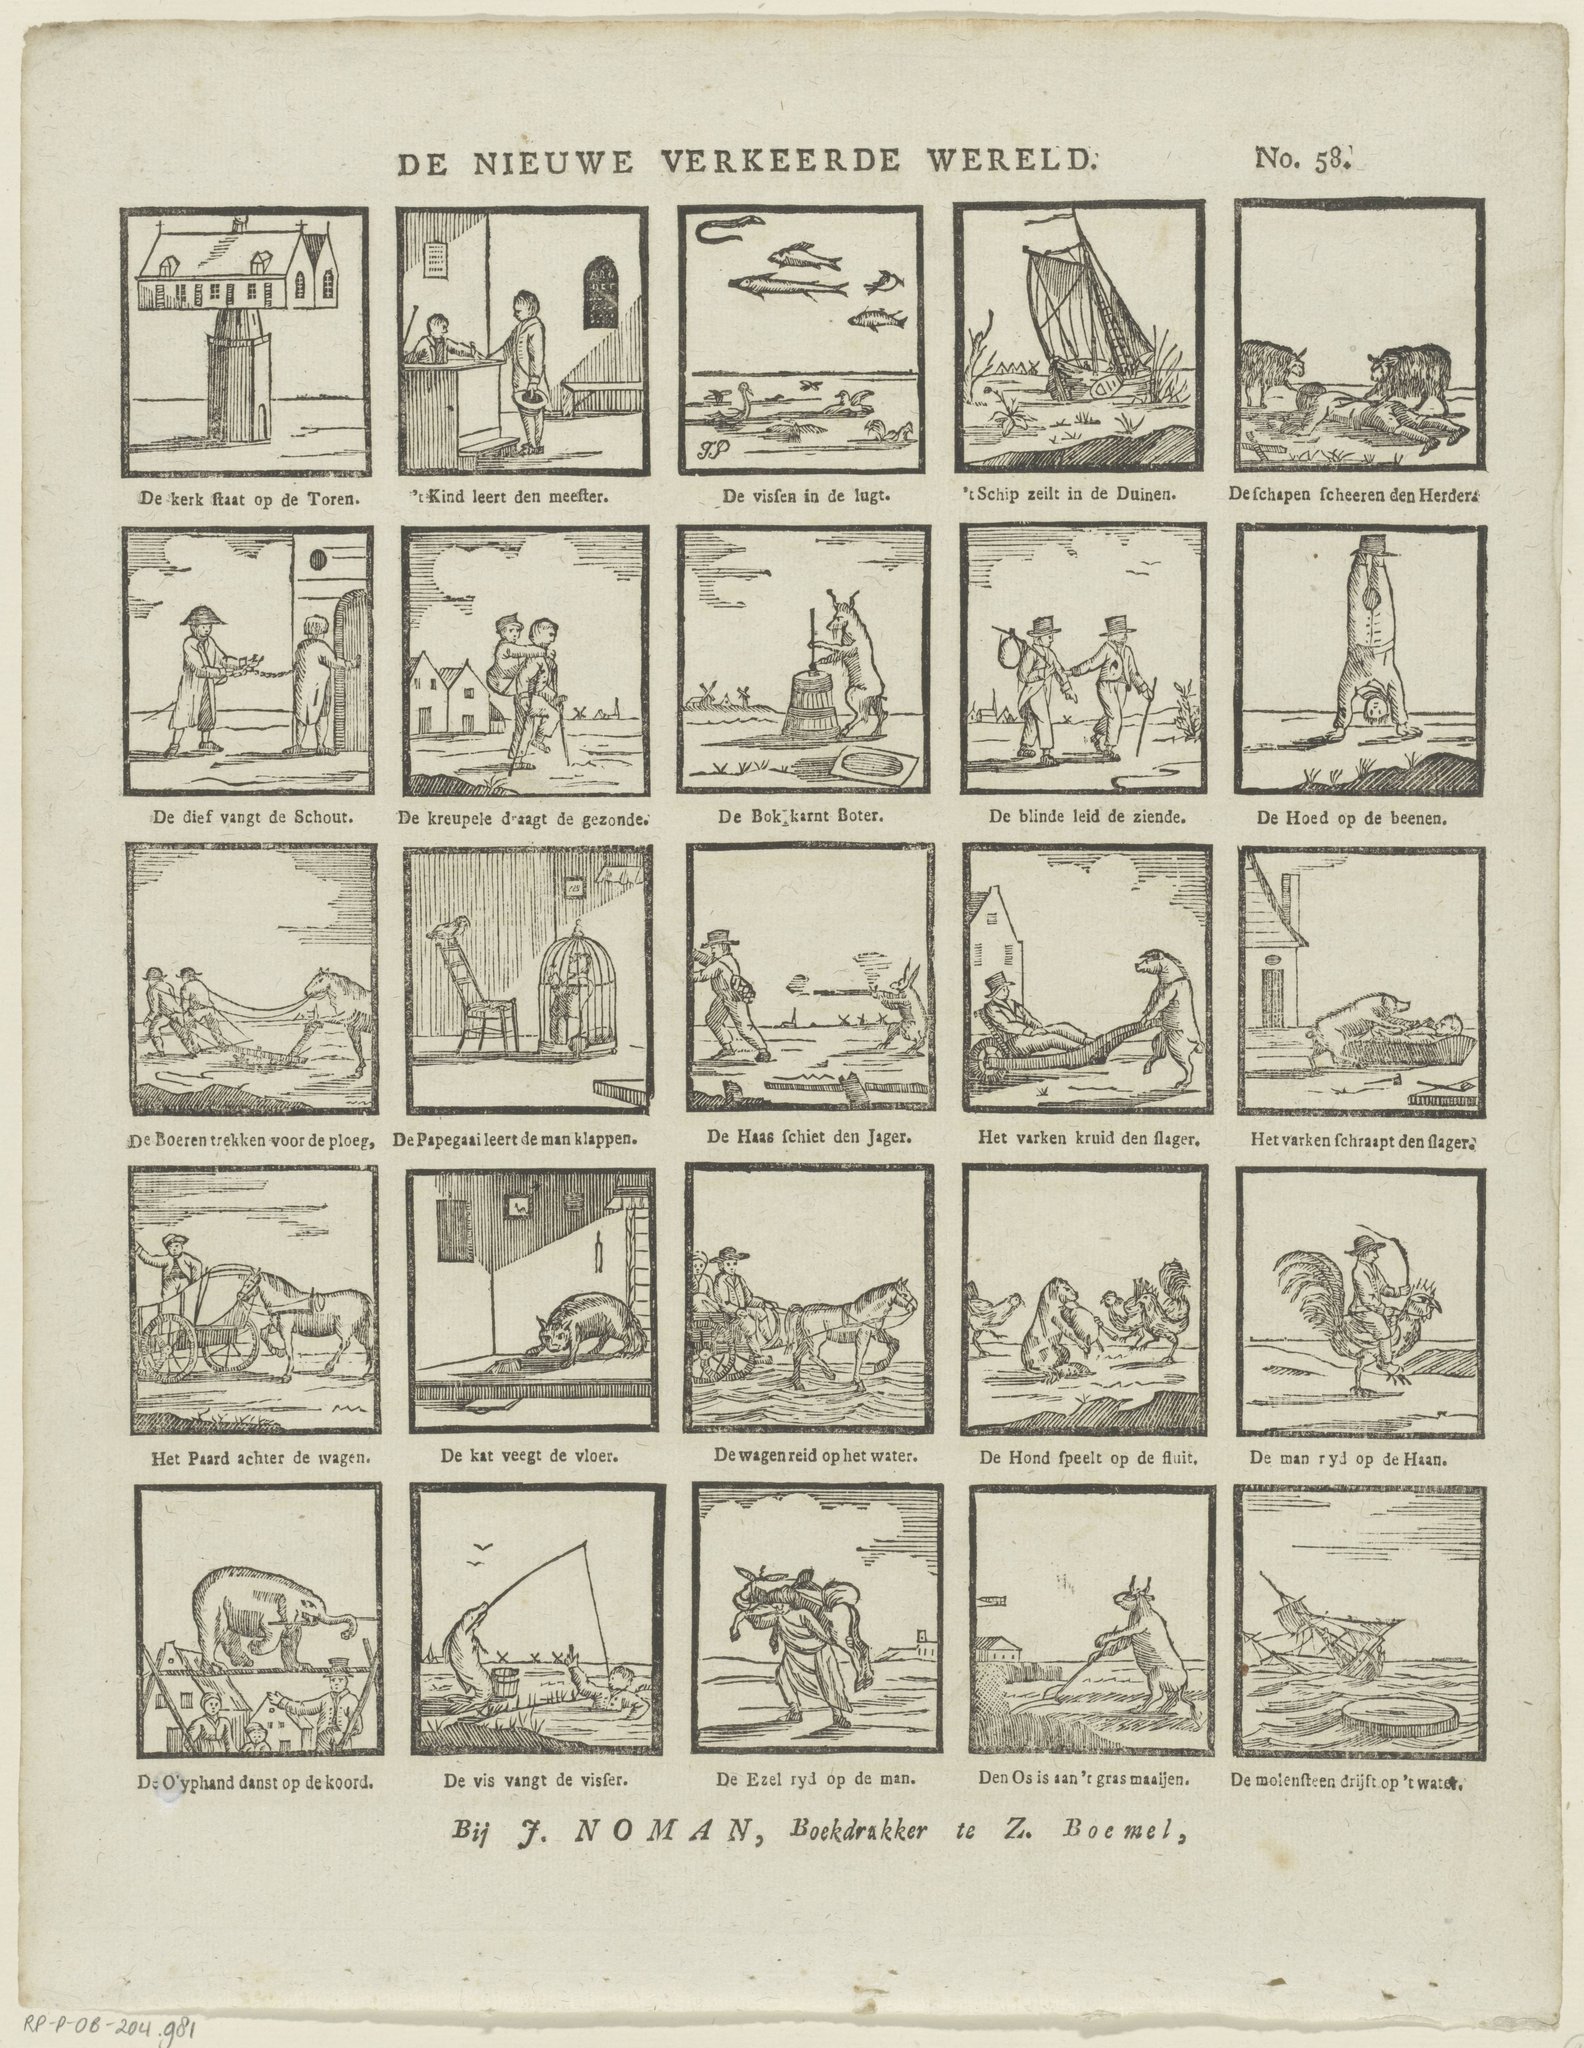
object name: print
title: De nieuwe verkeerde wereld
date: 1806-1830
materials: paper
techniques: letterpress printing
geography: zaltbommel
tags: 'mundus inversus', the reversed world, the topsy-turvy world, 'le monde bestourné', animals acting as human beings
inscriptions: collector's mark: Lugt 2760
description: Blad met 25 voorstellingen van de verkeerde wereld, waar onder andere dieren zich als mensen gedragen. Onder elke afbeelding een onderschrift. Genummerd rechtsboven: No. 58.